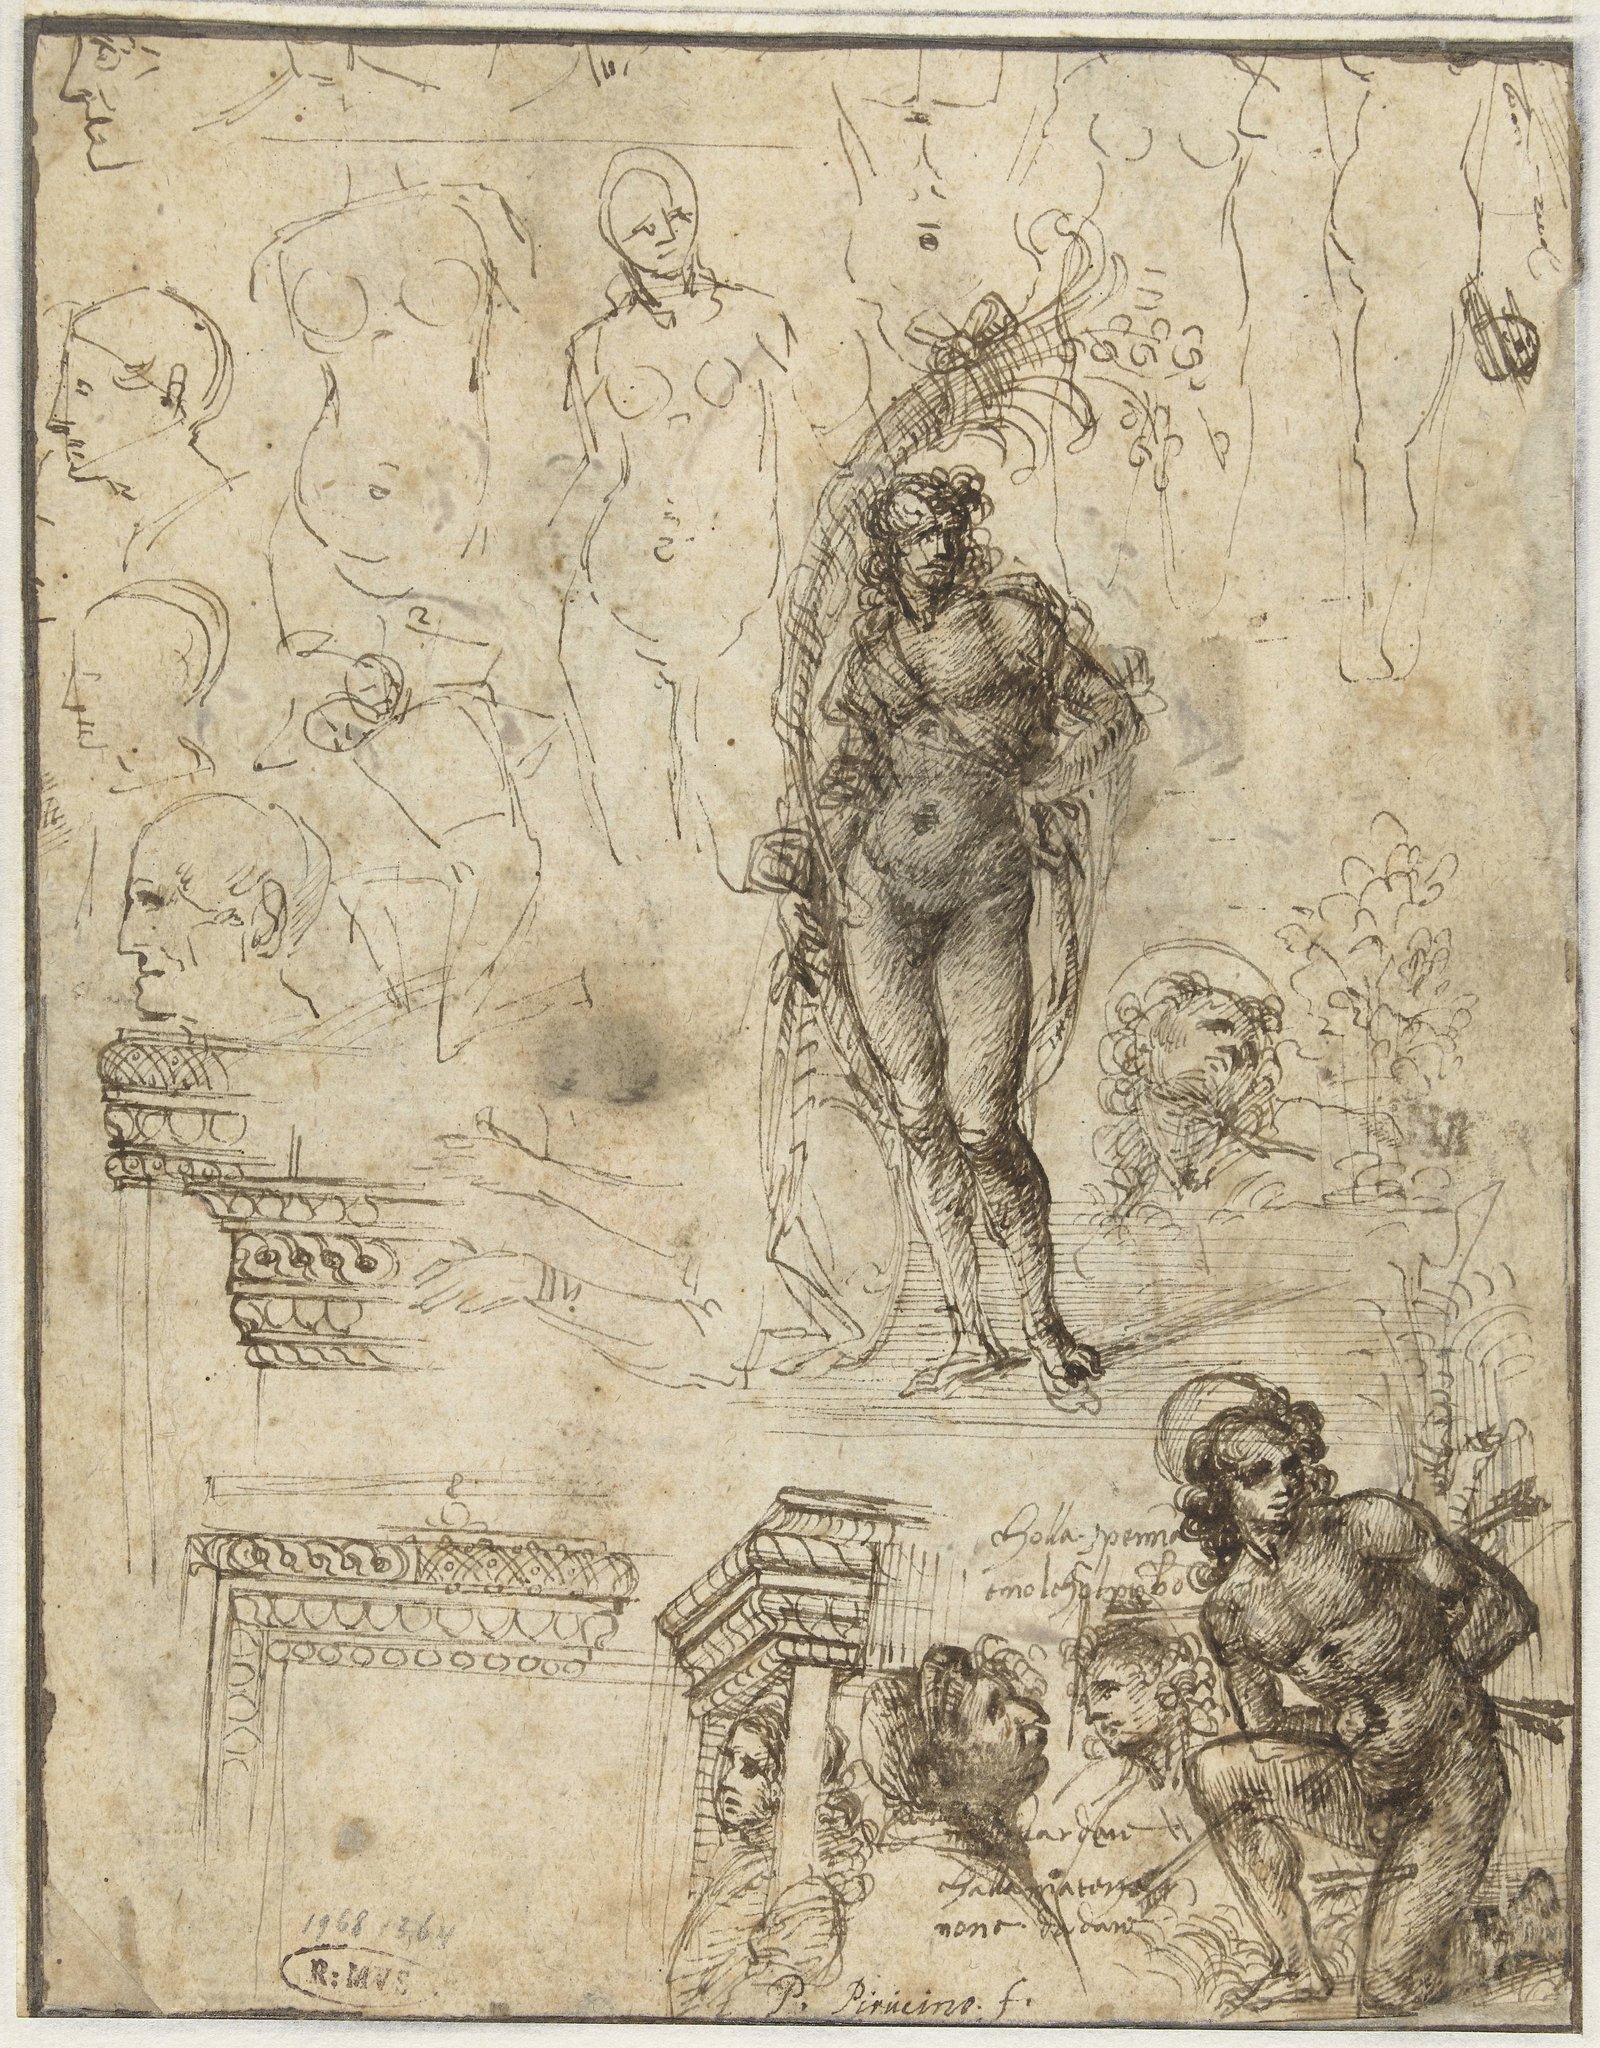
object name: drawing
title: Study Sheet with Heads, Figures and Architectural Fragments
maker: piero di cosimo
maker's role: draughtsman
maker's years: 1462-1522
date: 1490-1520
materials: ink, paper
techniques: pen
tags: the martyr sebastian; possible attributes: arrow(s), bow, tree-trunk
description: The female nudes at the top of this page of studies are drawn in various poses. One pose, with the weight resting on one leg (contrapposto), is worked out in more detail in the figure at centre. In addition, there are faces, architectural details and a kneeling, nude figure of St Sebastian. These studies reveal the curiosity and restless searching of Renaissance artist Piero di Cosimo.